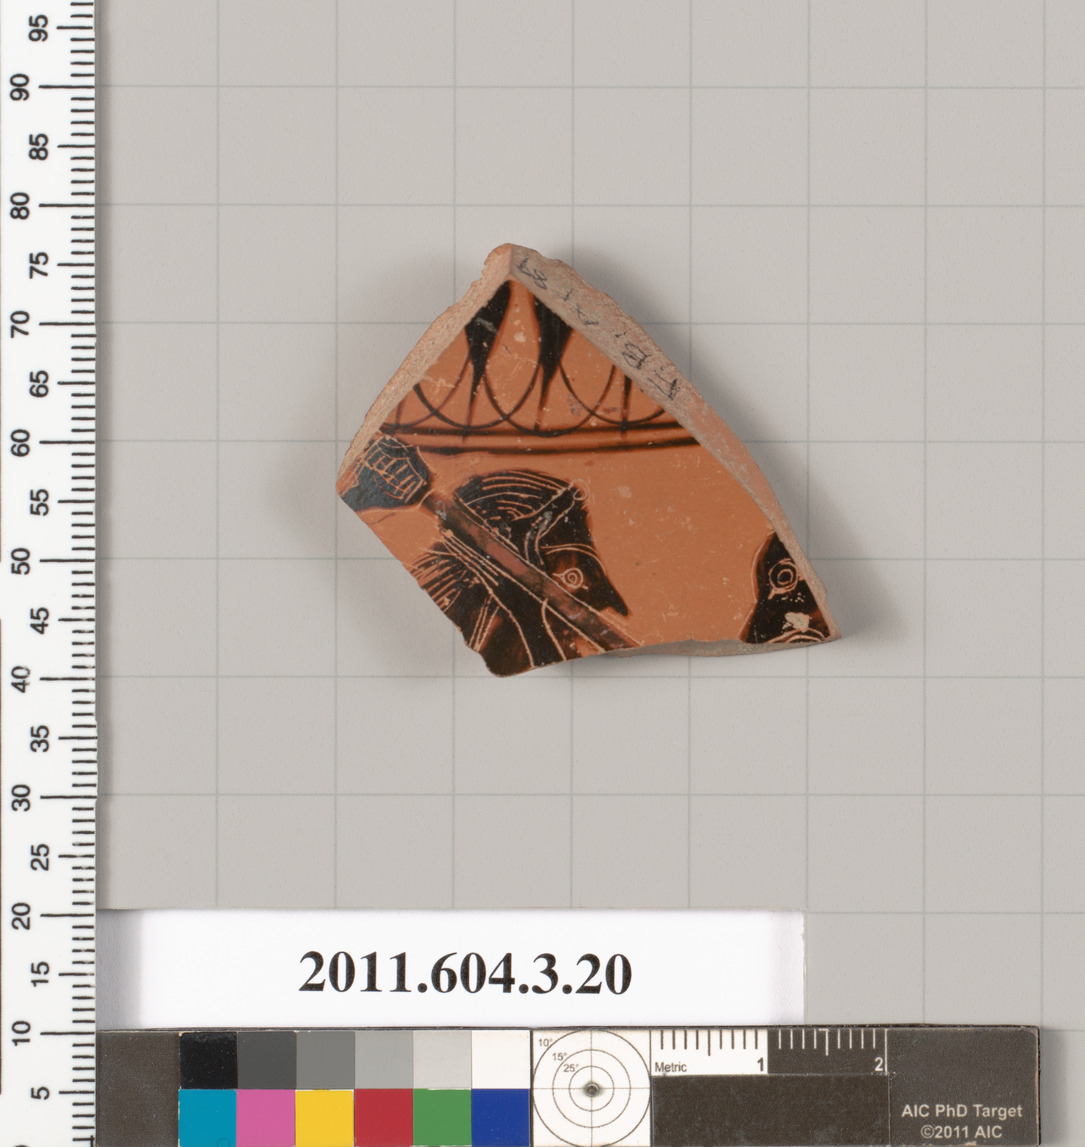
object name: neck amphora fragment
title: Terracotta fragment of a neck-amphora (jar)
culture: greek, attic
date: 550-525 BCE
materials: terracotta